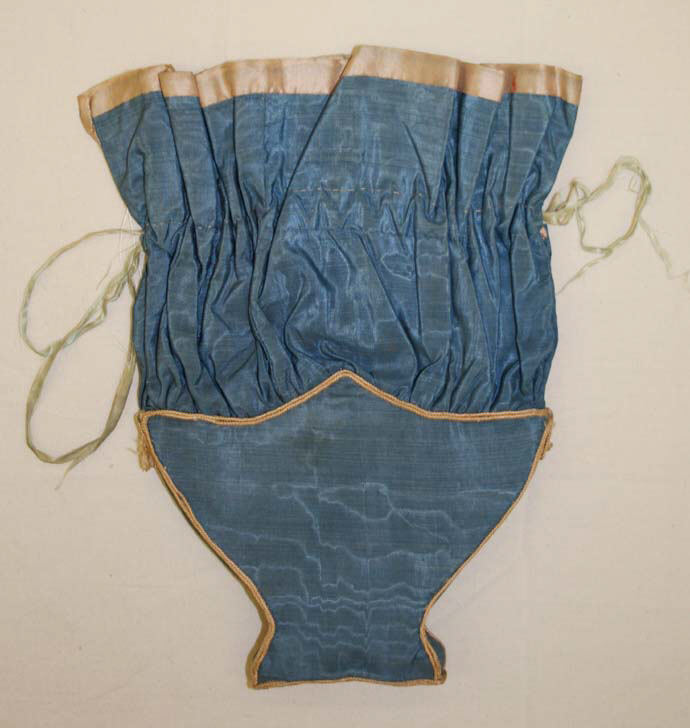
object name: bag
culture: italian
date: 1880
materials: silk